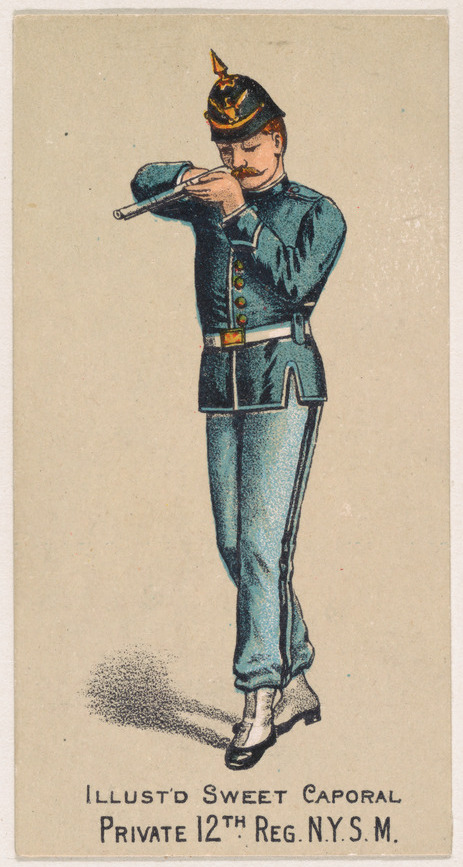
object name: print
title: Private, 12th Regiment, New York State Militia, from the Military Series (N224) issued by Kinney Tobacco Company to promote Sweet Caporal Cigarettes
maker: kinney brothers tobacco company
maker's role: publisher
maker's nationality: american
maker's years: 1869-2011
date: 1888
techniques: color lithograph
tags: military,men